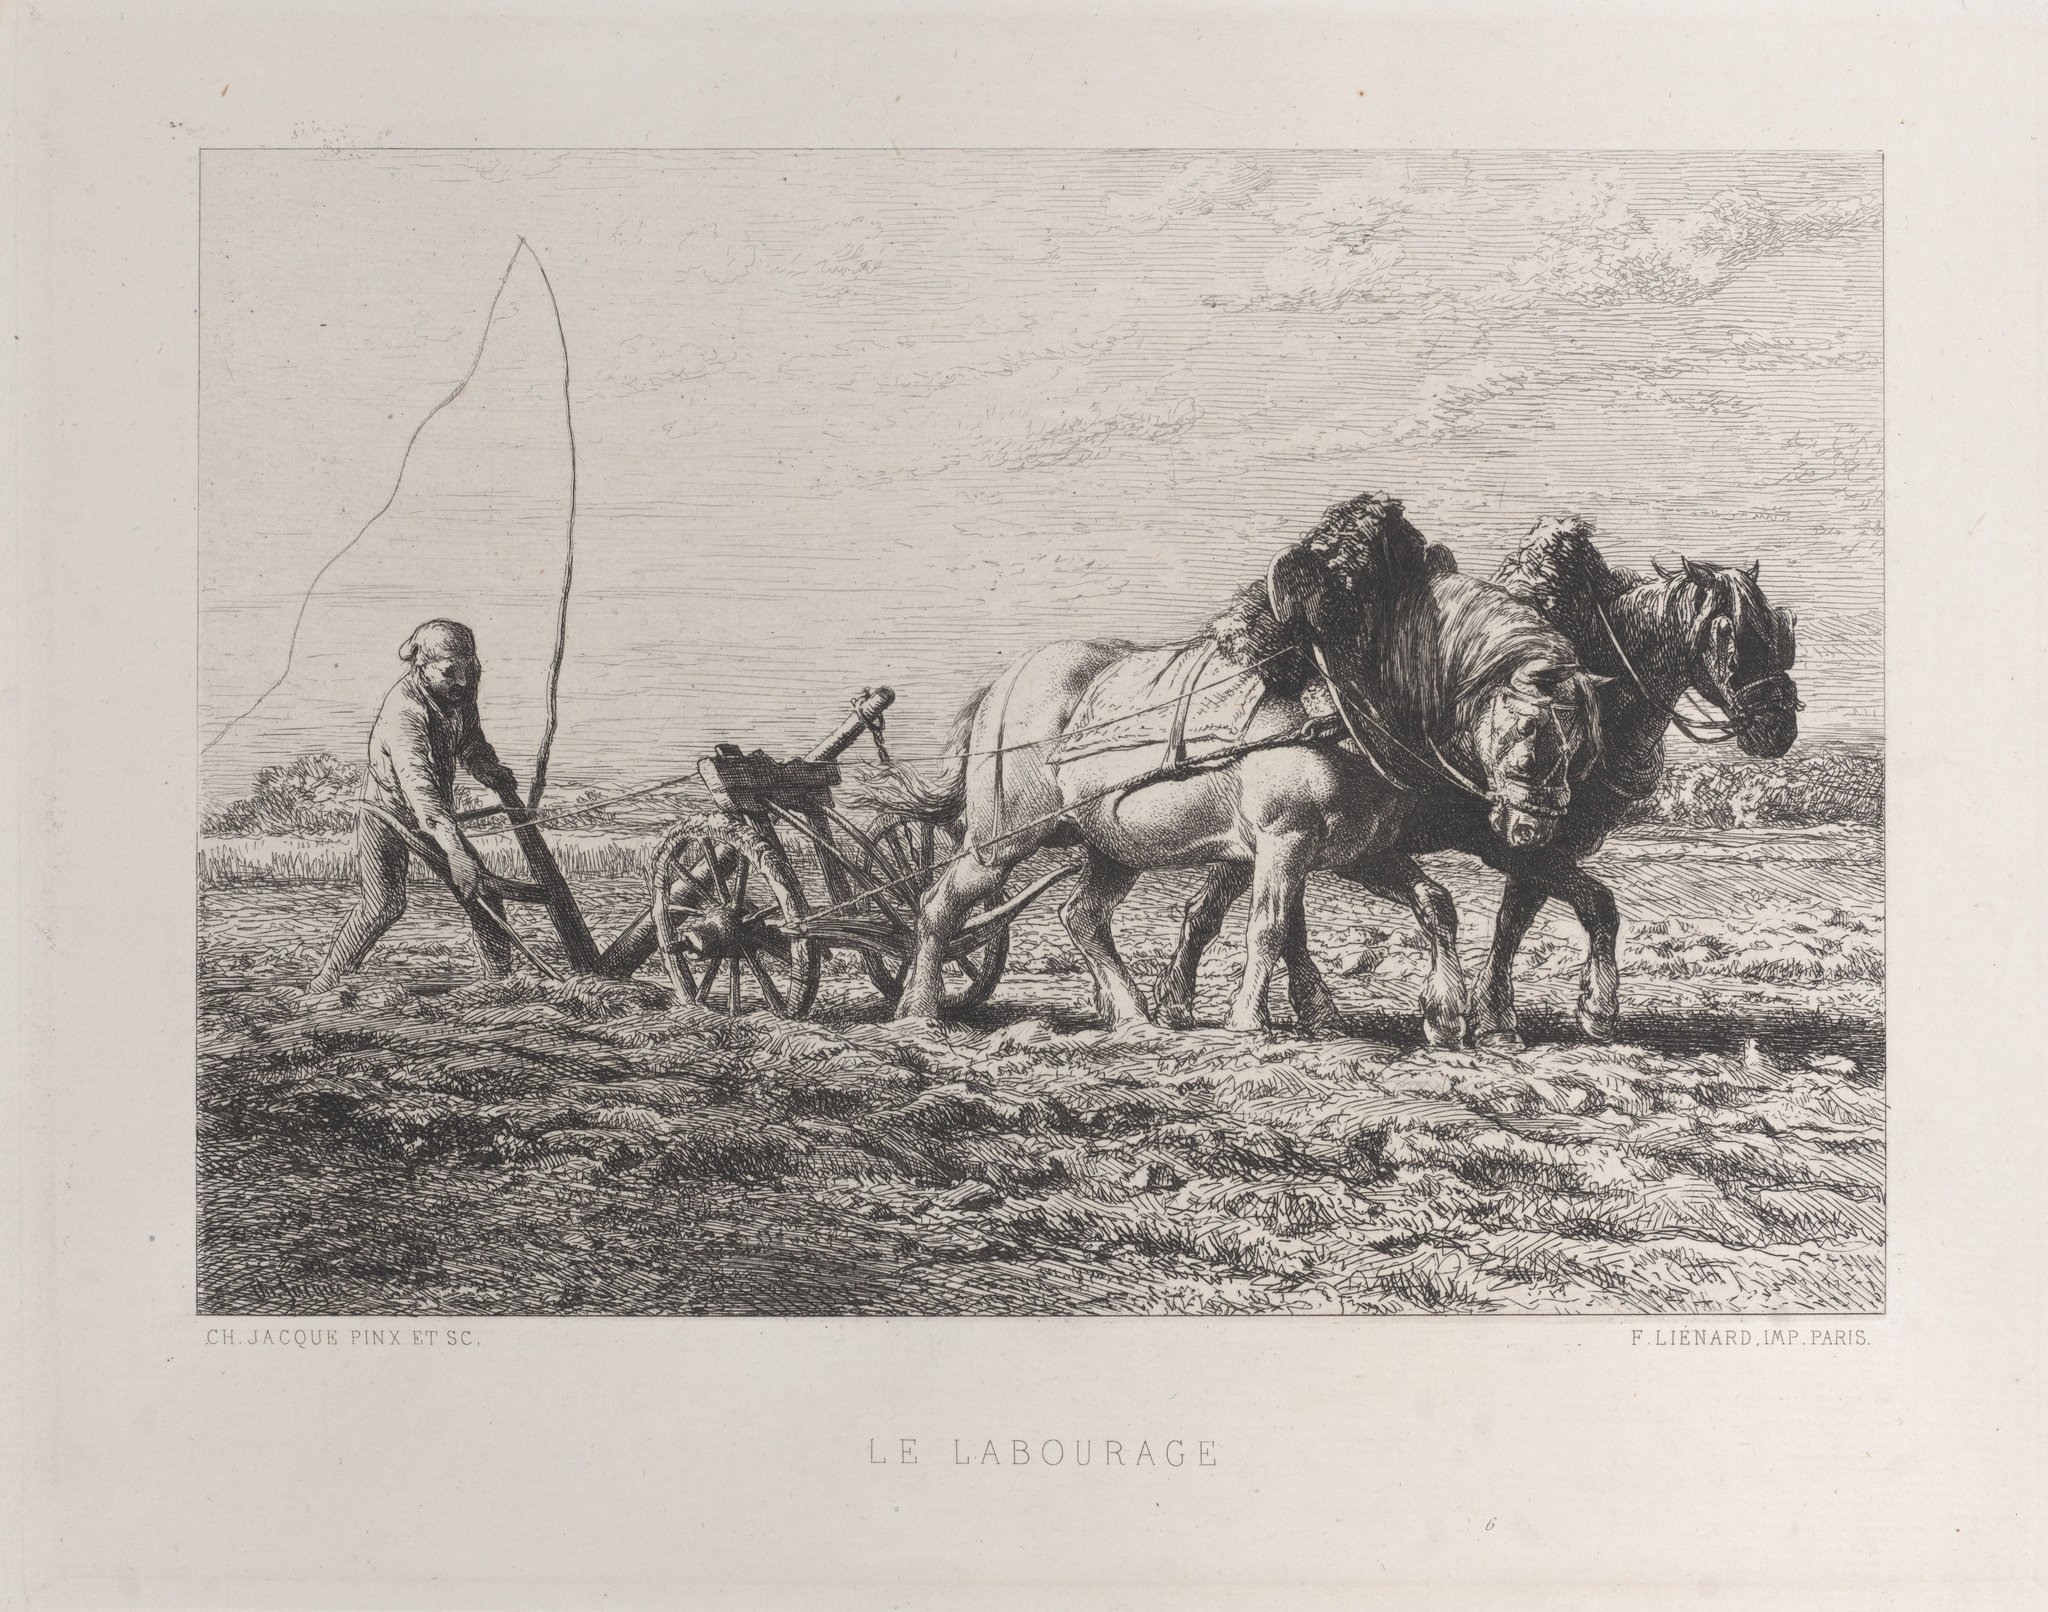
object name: print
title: Plowing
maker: charles émile jacque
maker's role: artist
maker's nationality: french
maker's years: 1813-1894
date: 1864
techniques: etching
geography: paris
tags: men,horses,plows